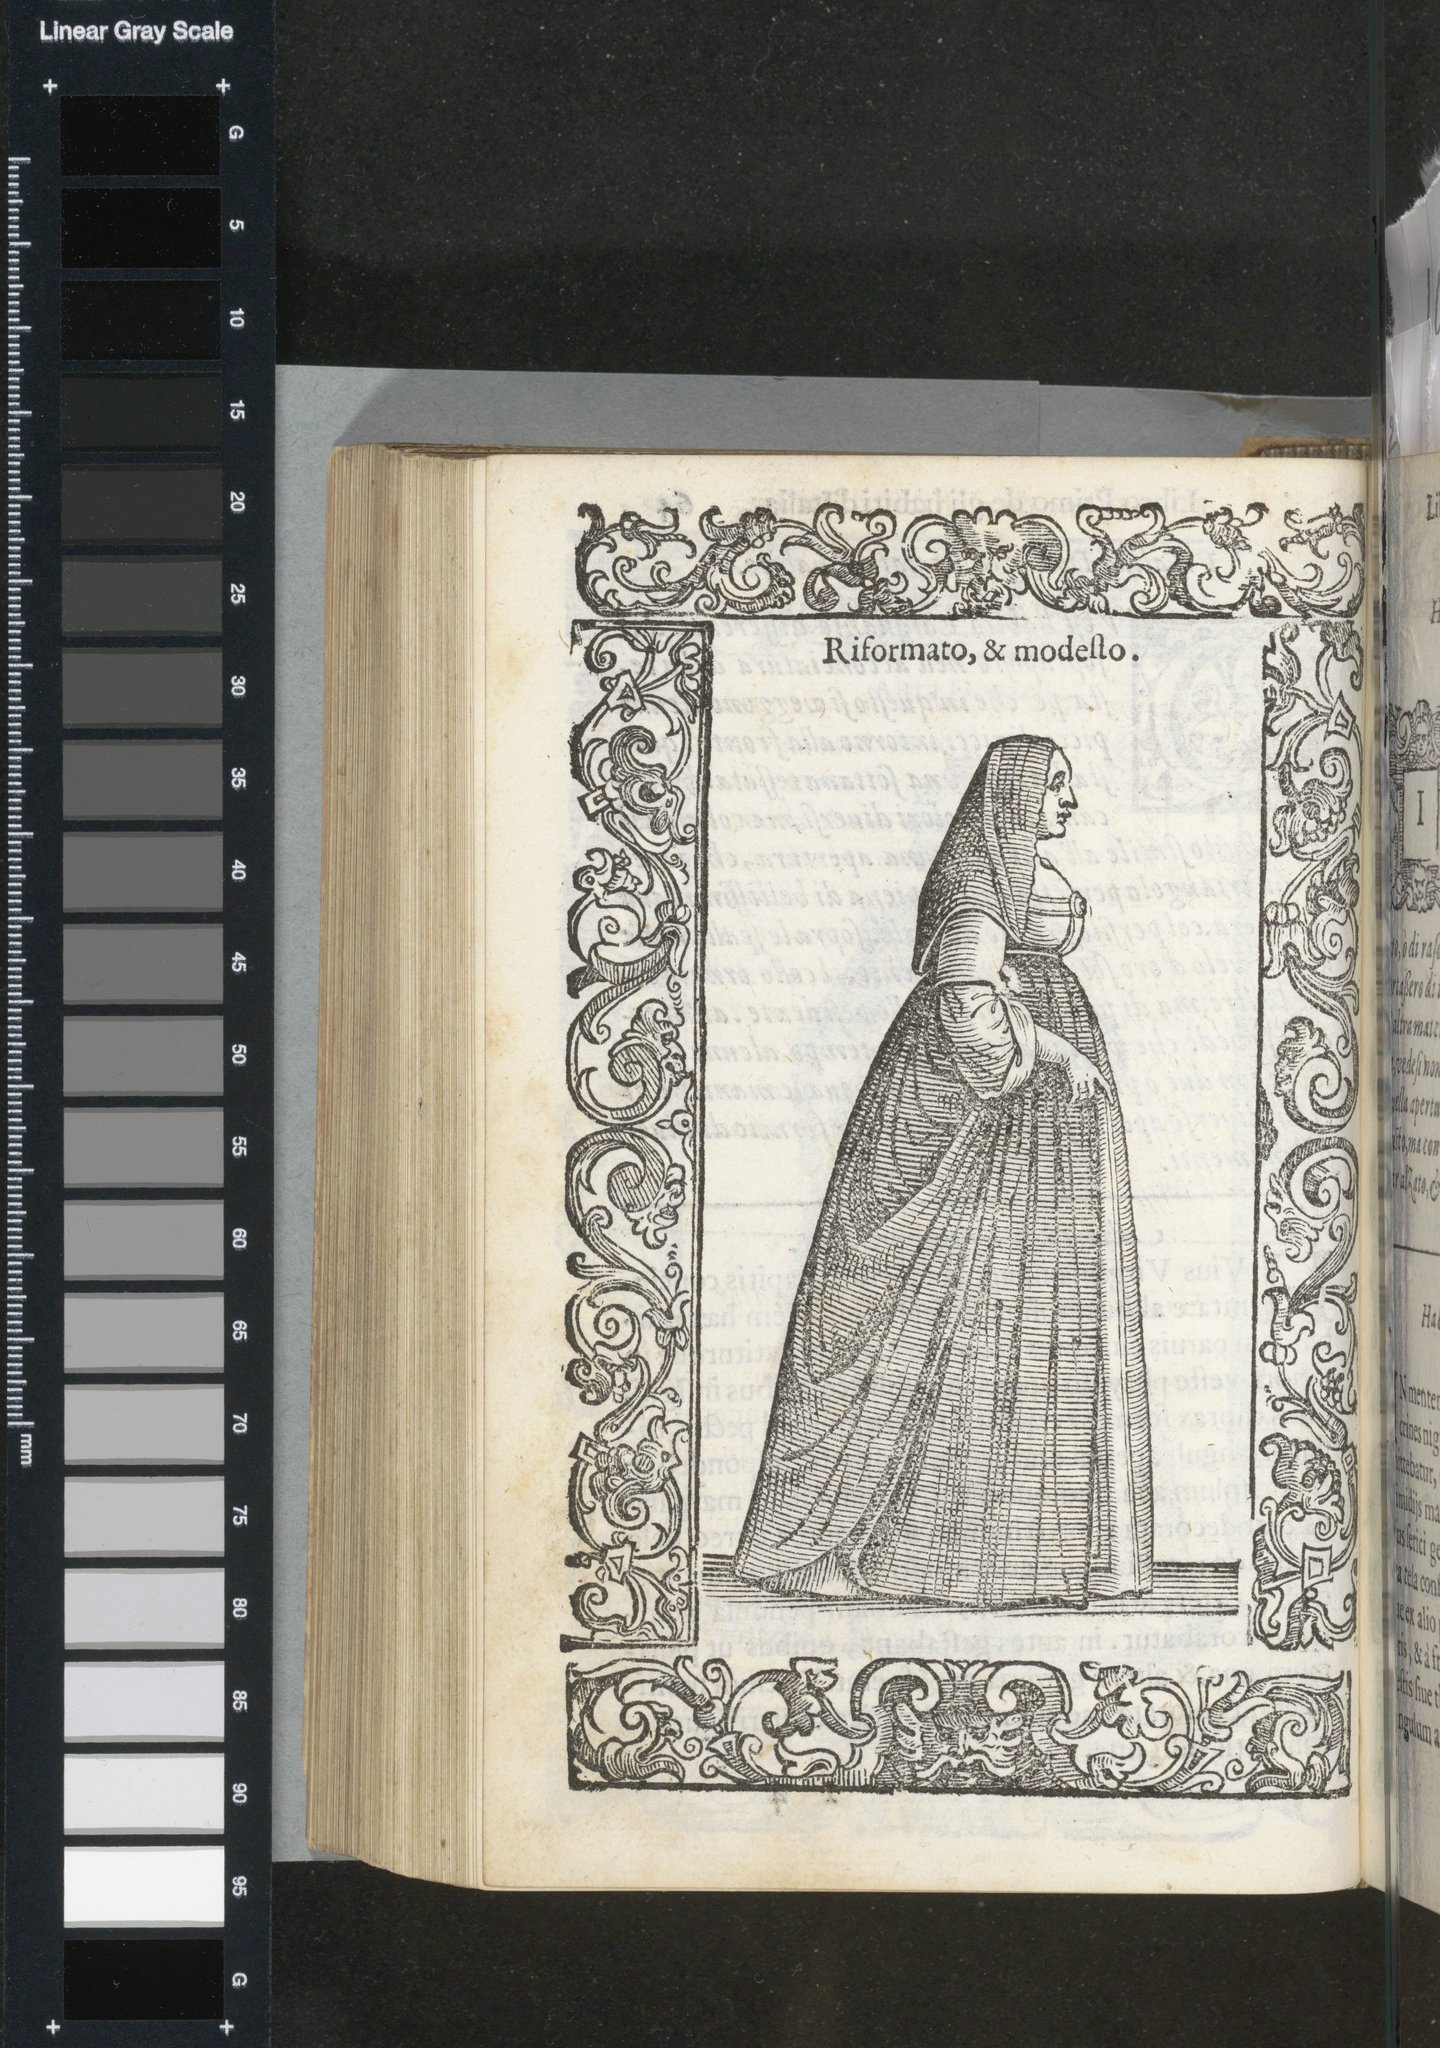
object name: costume print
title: Riformato & modesto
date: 1598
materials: paper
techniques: woodcut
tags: fashion plates